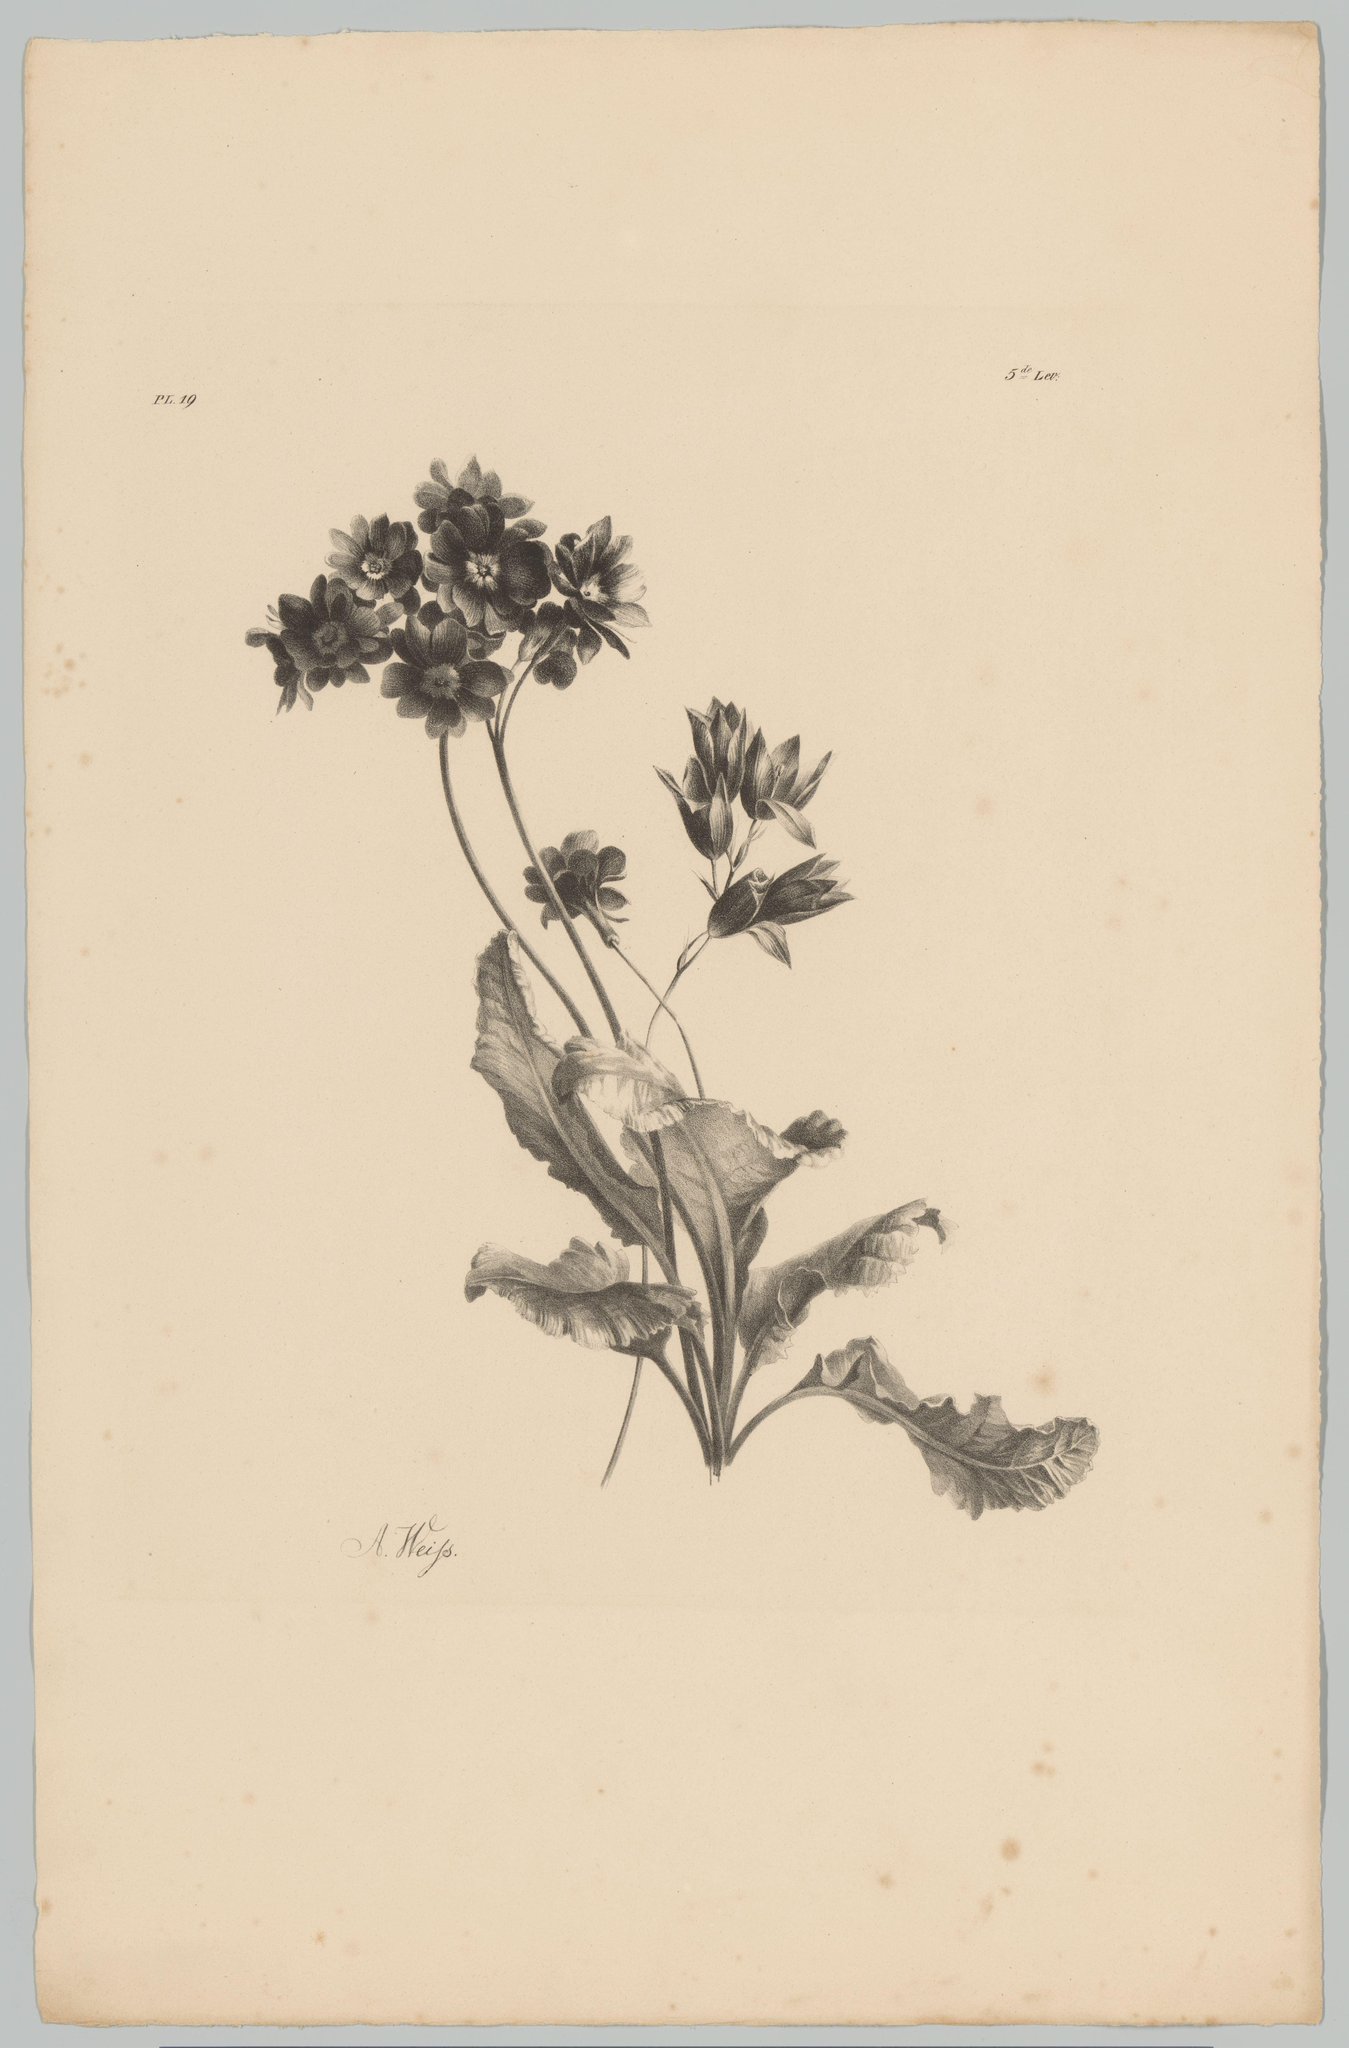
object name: print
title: Diverse bloemen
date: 1820-1833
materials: paper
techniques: lithograph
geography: amsterdam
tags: flowers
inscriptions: collector's mark: Lugt 2228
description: Rechts boven genummerd 5de Lev. Onderdeel van een omslag met in totaal zevenenzeventig lithografieën van bloemen en fruit.